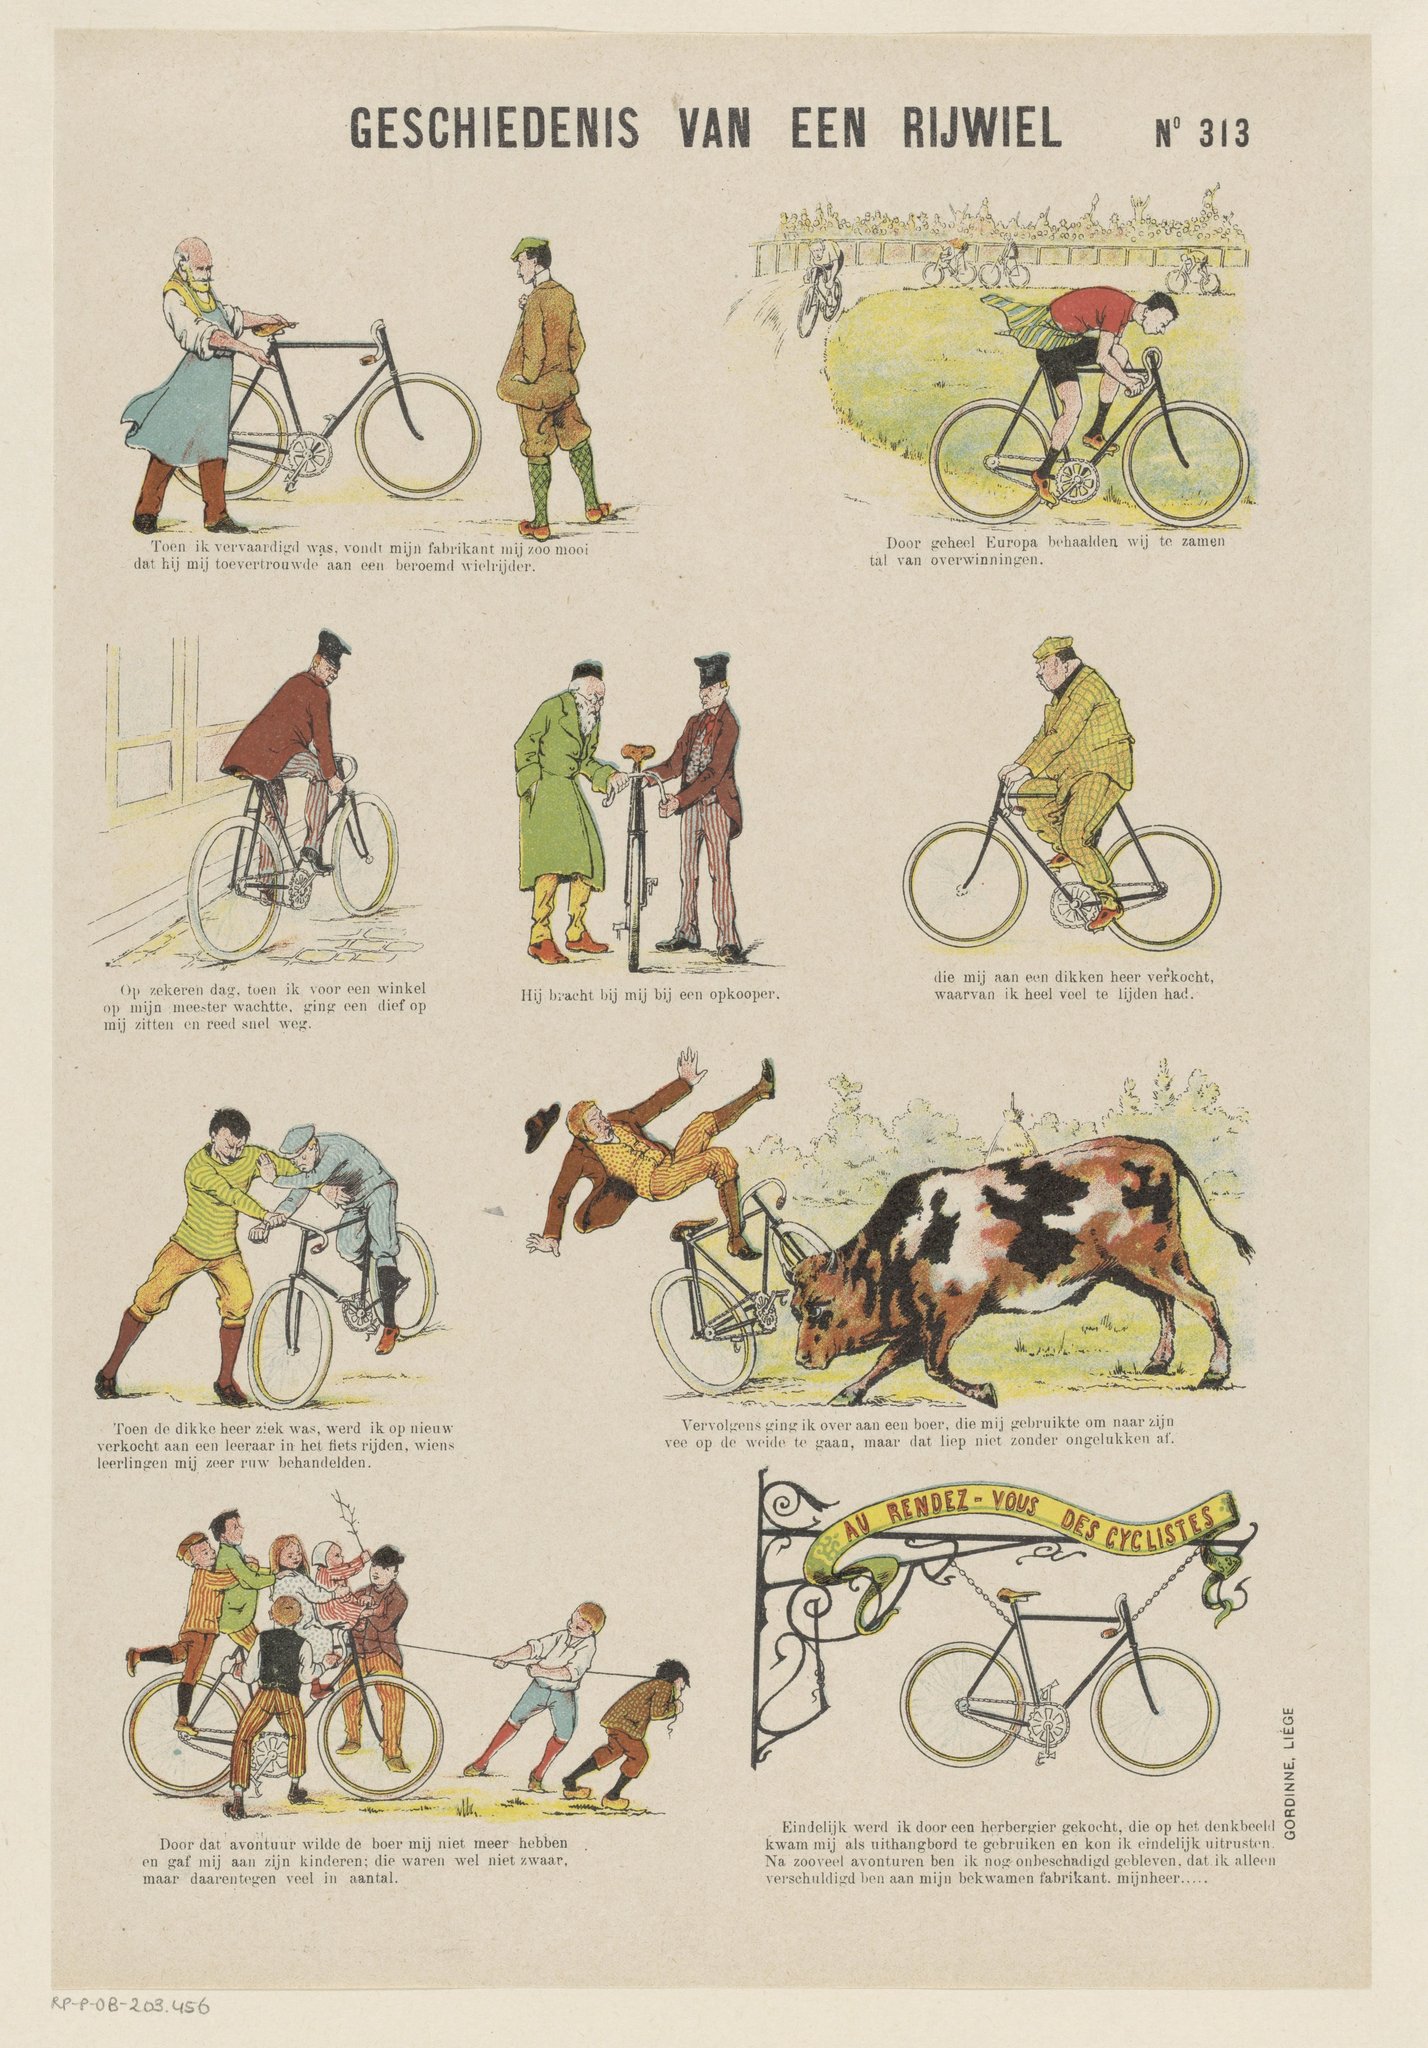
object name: print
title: Geschiedenis van een rijwiel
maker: Anonymous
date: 1894-1959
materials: paper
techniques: lithograph, letterpress printing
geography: liège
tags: bicycle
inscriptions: collector's mark: Lugt 2760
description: Blad met 9 voorstellingen over een fiets die meerdere malen van eigenaar wisselt. Onder elke afbeelding een onderschrift. Genummerd rechtsboven: No 313.